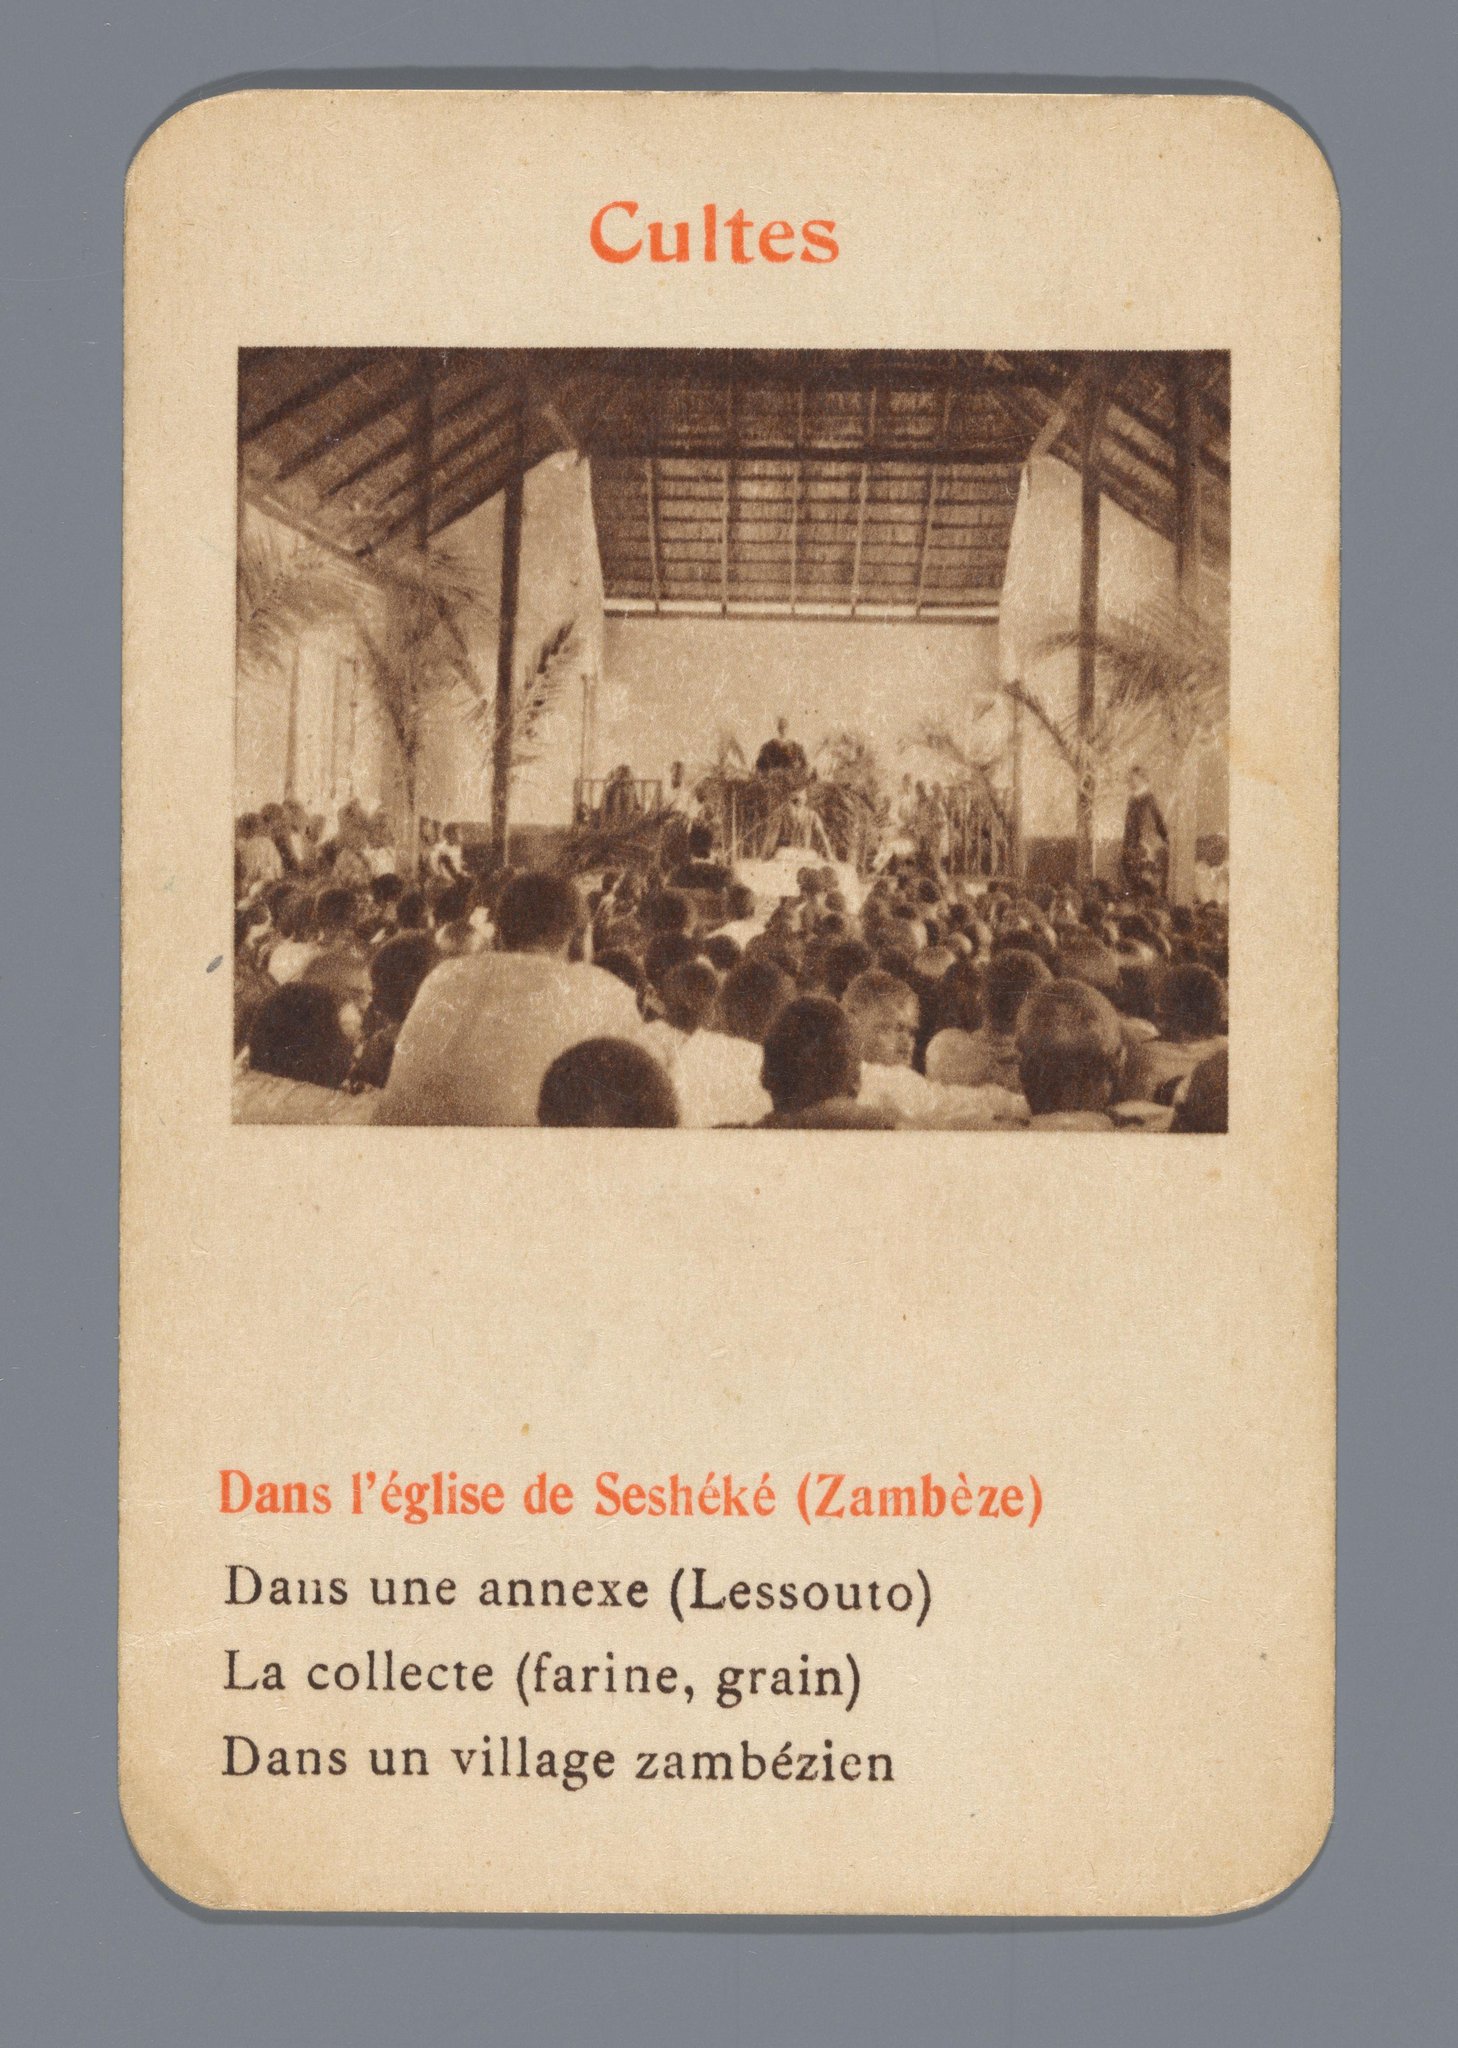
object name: card game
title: Interieur van de kerk van Sesheke tijdens een dienst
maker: Anonymous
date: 1900-1920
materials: cardboard, paper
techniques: rotogravure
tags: african traditional religions, card games